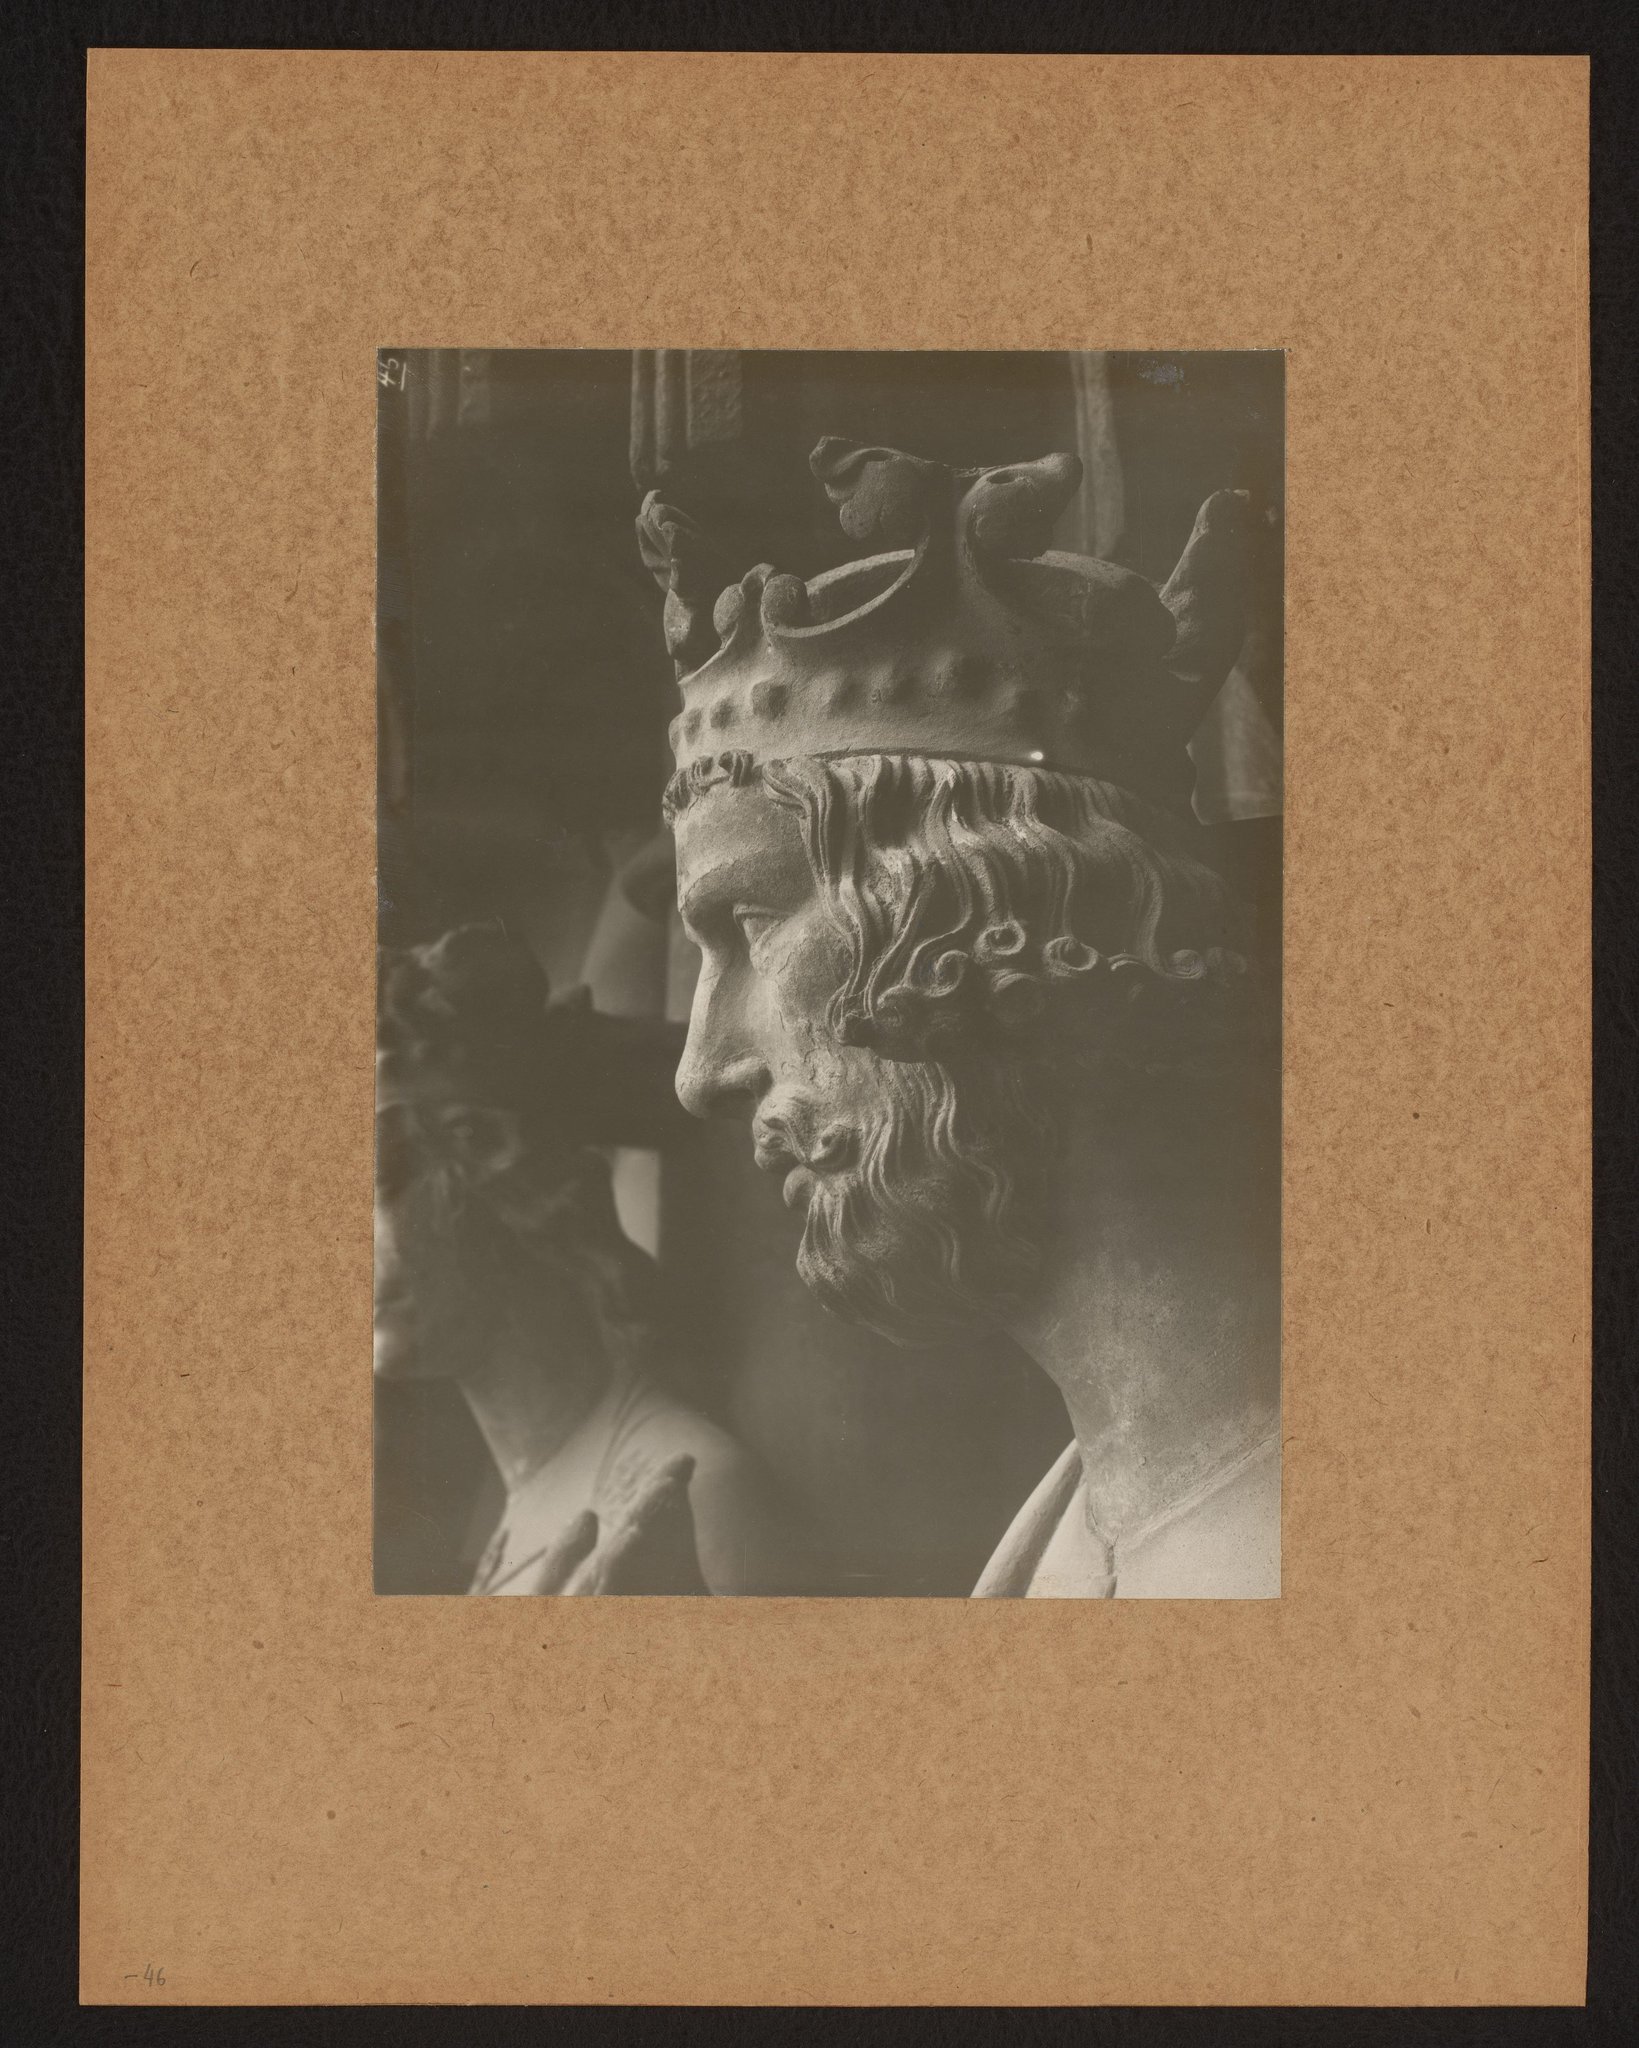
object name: photograph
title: Adamspforte, Kopf v.rechts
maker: Anonymous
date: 1900-1920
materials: paper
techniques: gelatin silver print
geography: bamberg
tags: church (exterior)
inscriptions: number: ‘46.’